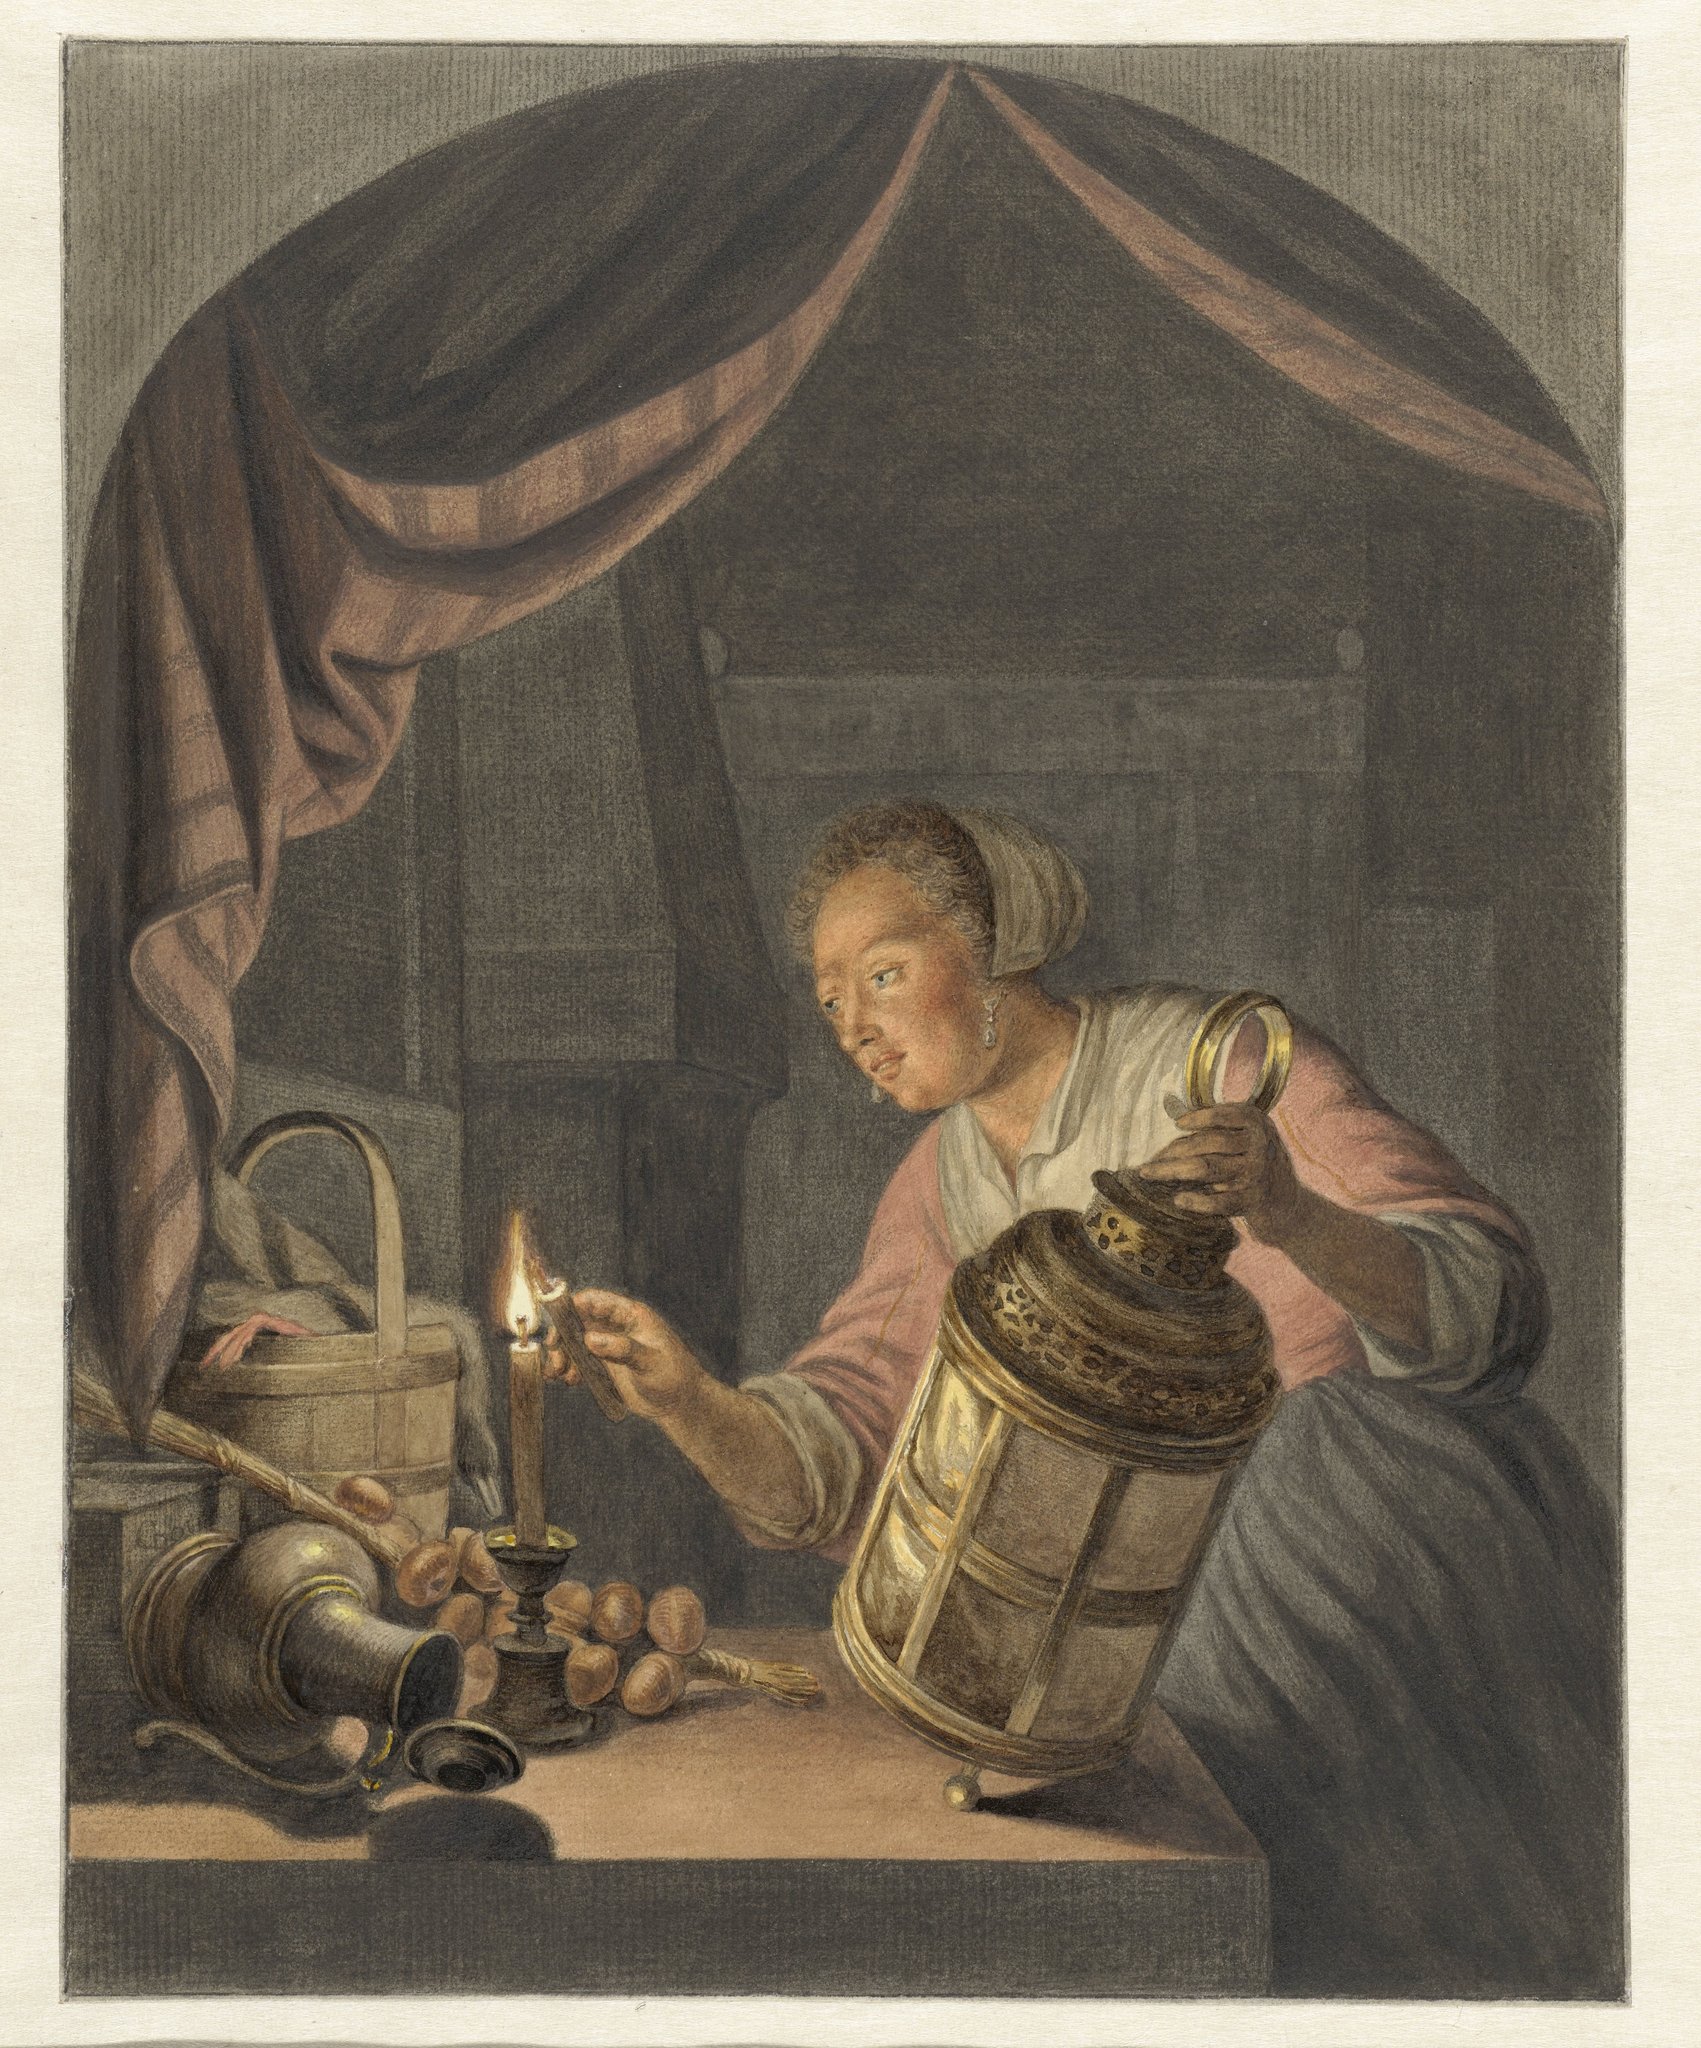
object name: drawing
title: Meisje, een lantaarn ontstekend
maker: abraham delfos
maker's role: draughtsman, painter, print maker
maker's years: 1731-1820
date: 1795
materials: chalk, ink, paper, watercolor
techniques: brush, pen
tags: kitchen-maid, kitchen servant, lantern (+ kindling a light; lit, burning light, lamp, candle)